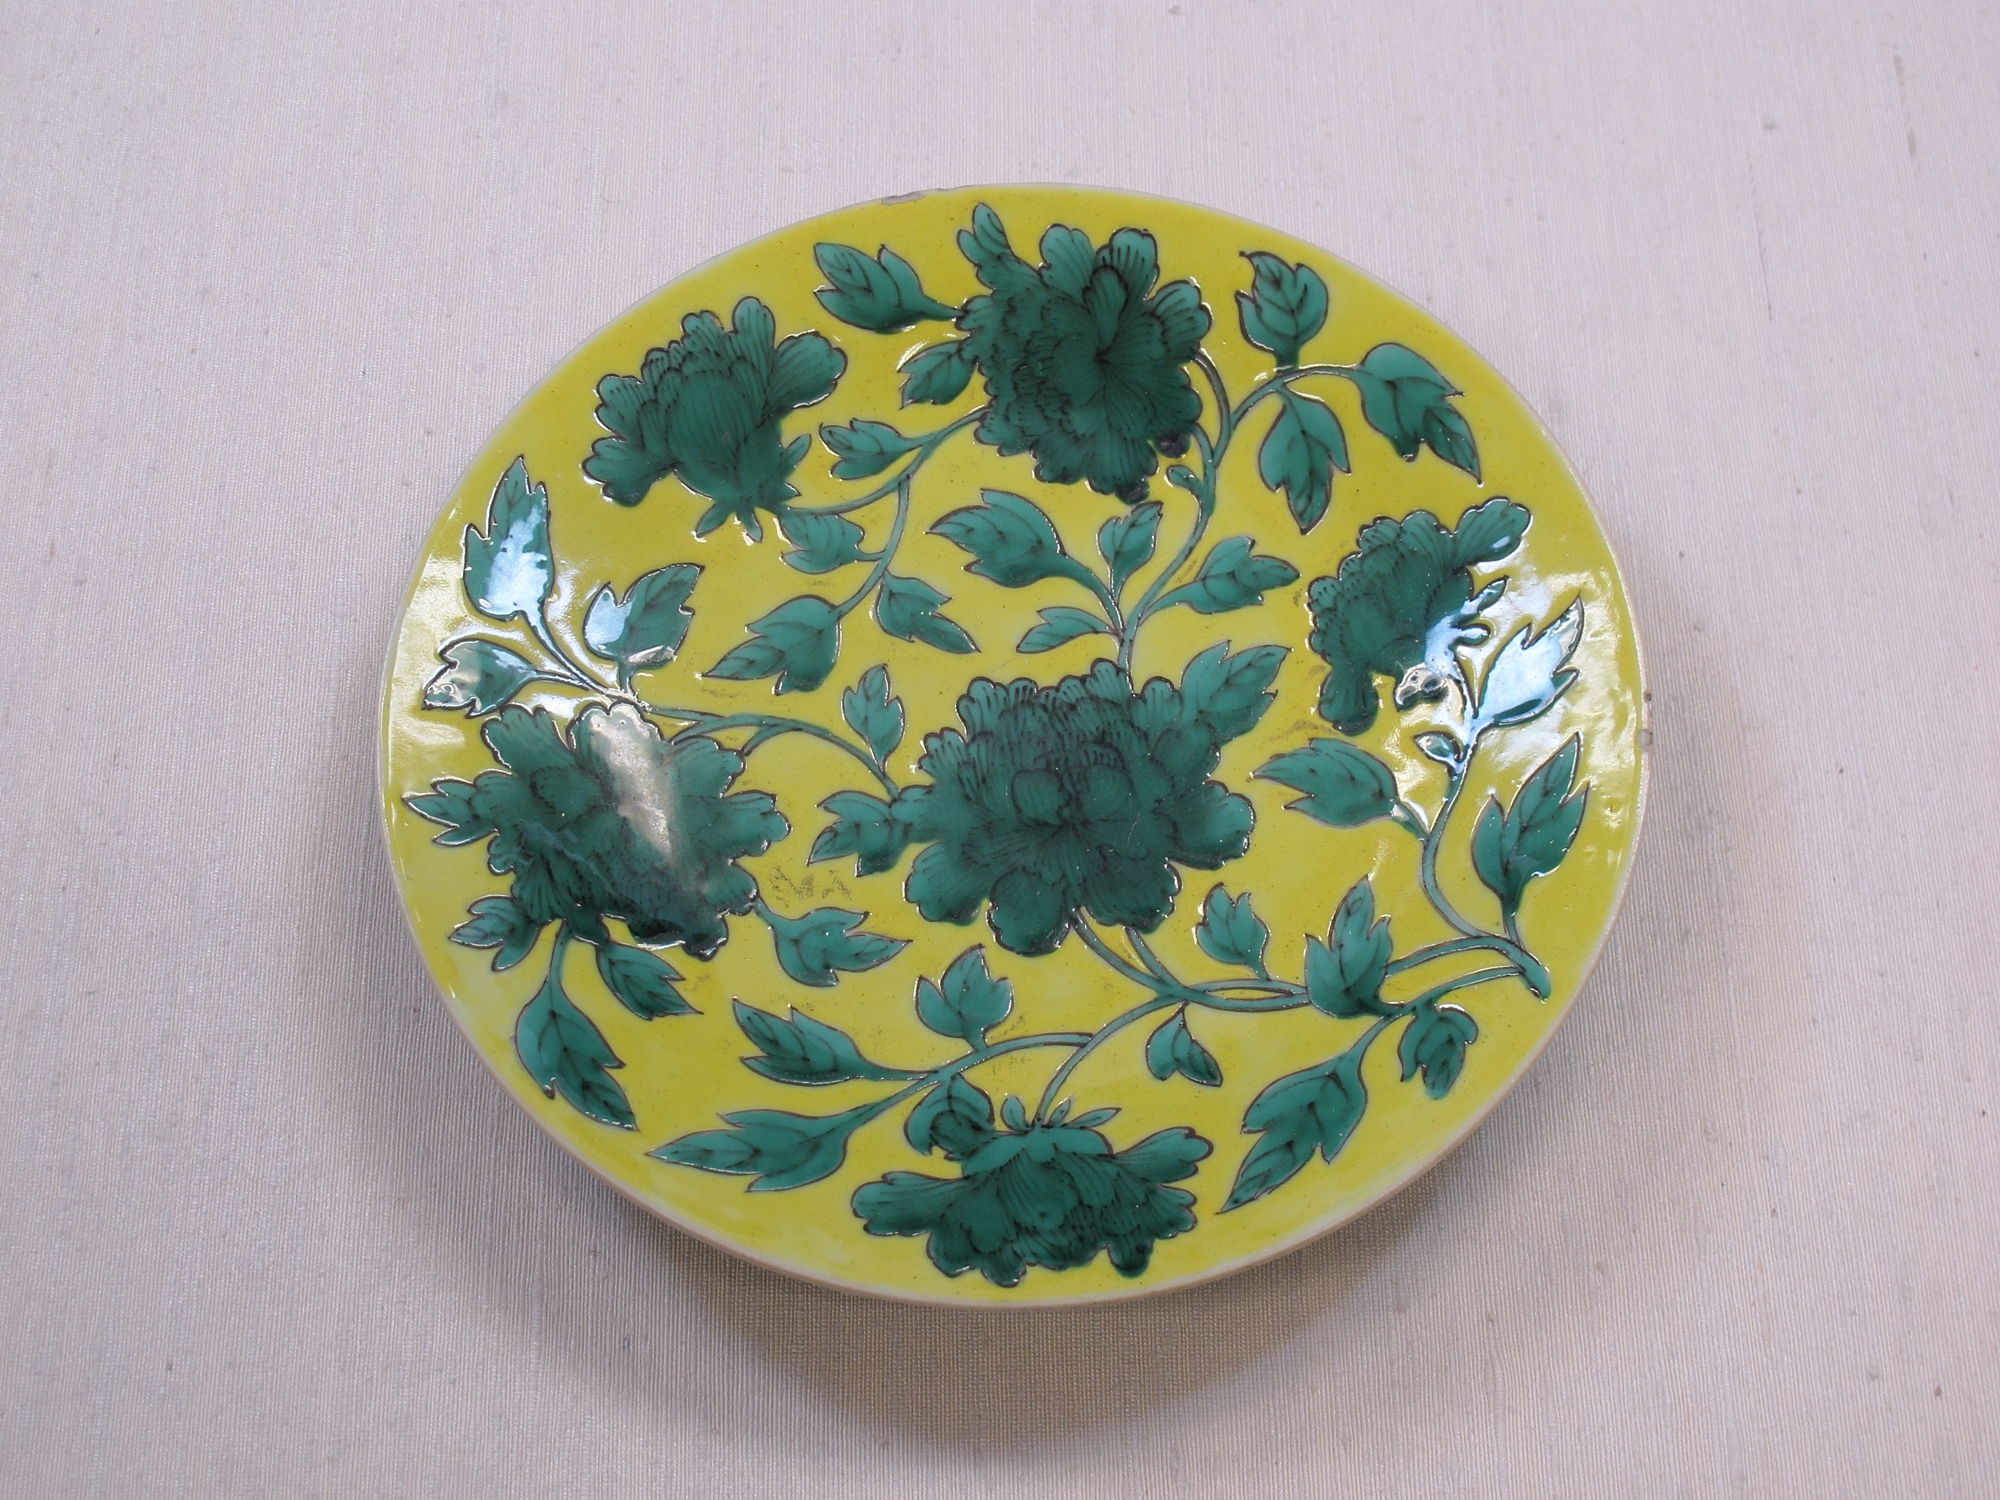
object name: dish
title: Dish with flowers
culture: chinese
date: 1801-1850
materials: enamel, porcelain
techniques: overglaze, painting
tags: flowers